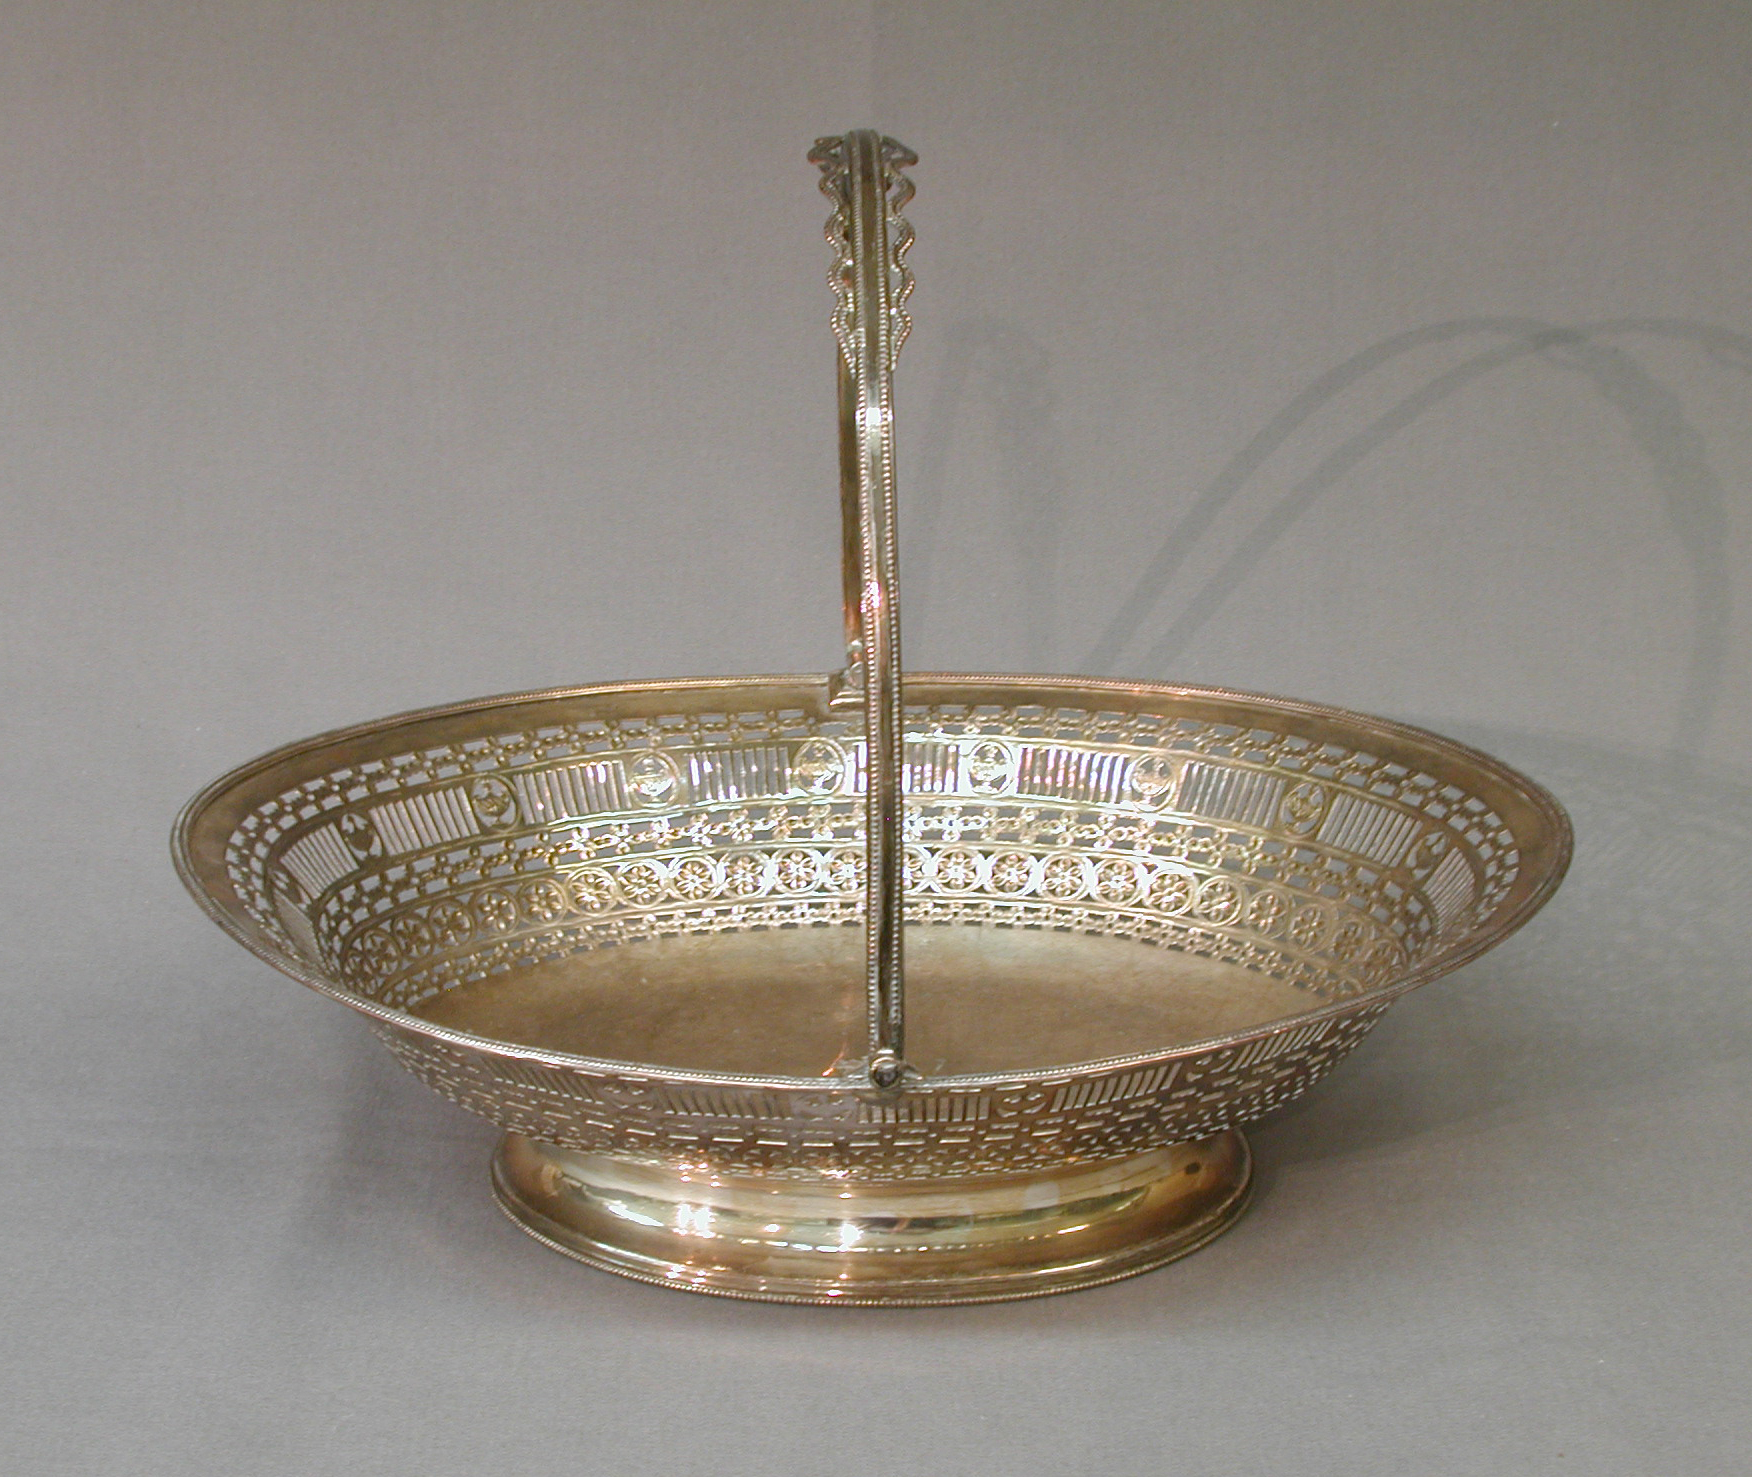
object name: cake basket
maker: tudor and leader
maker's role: maker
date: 1785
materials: metal